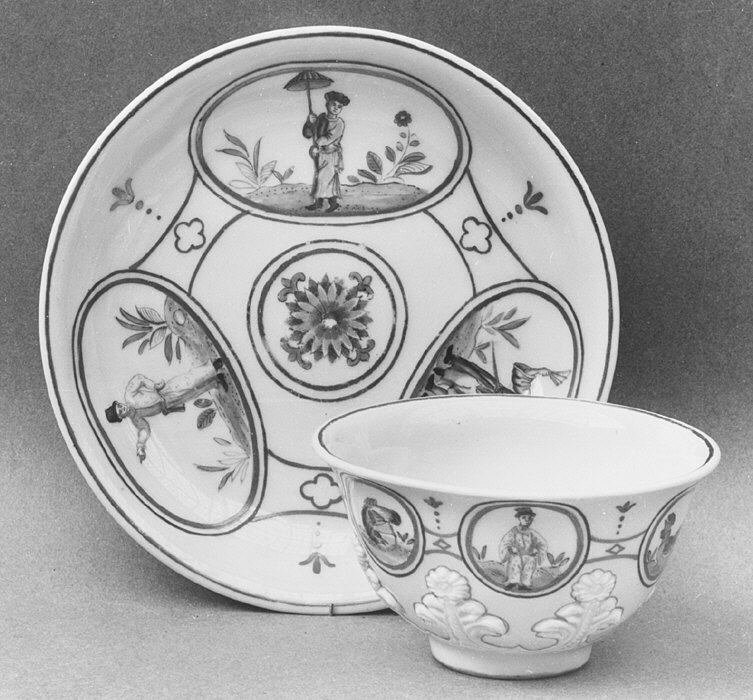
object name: cup and saucer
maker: vienna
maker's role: manufactory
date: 1720-1725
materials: hard paste porcelain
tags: human figures